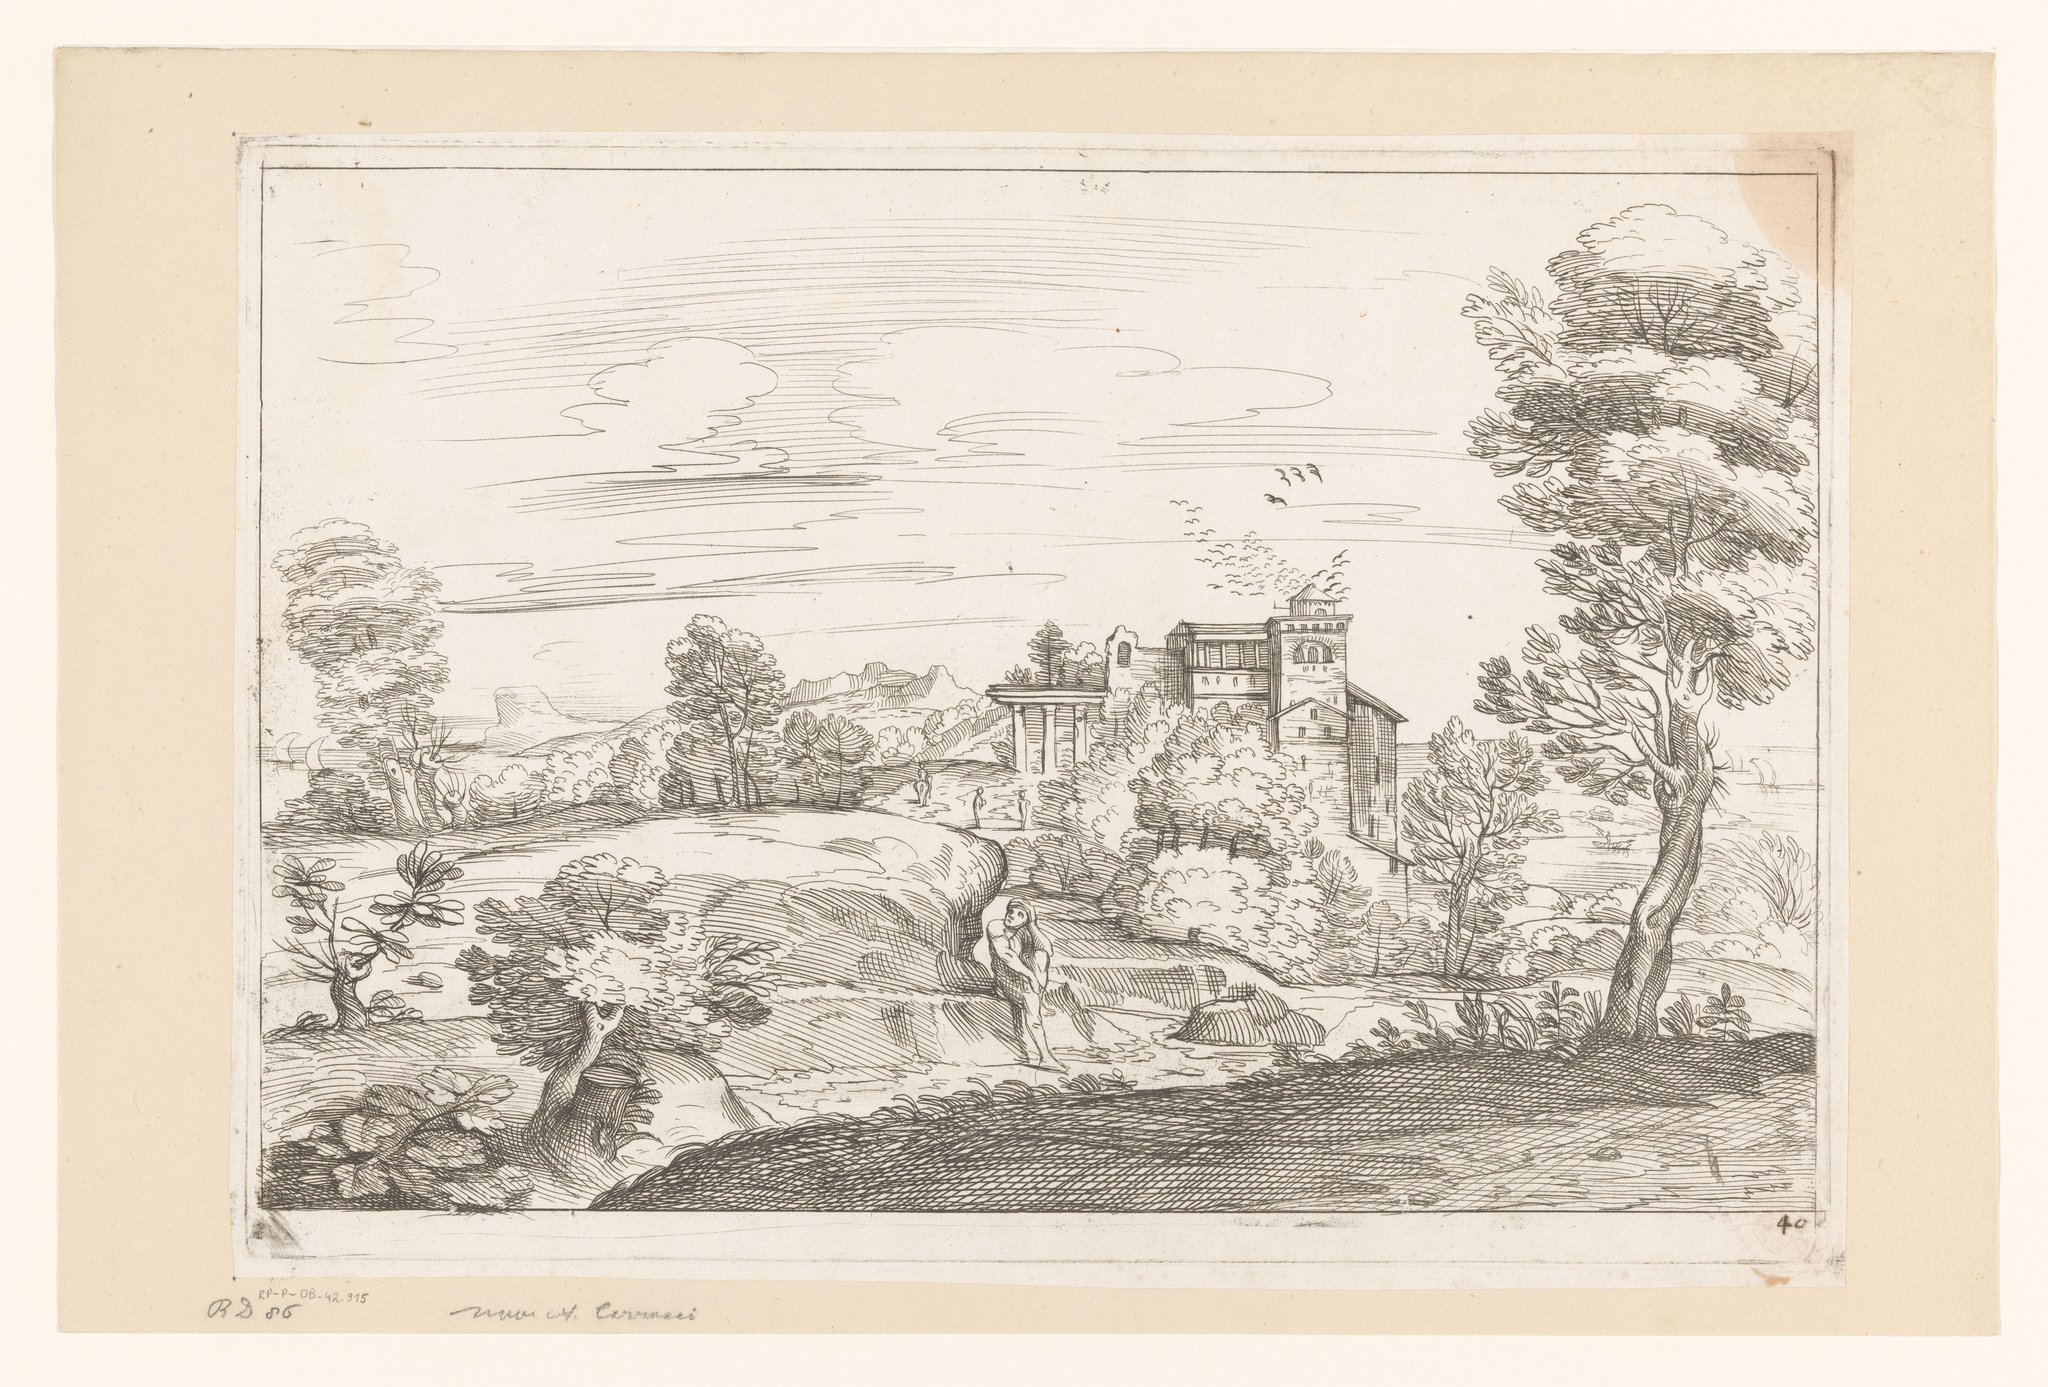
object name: print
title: Prenten naar tekeningen uit het kabinet Jabach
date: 1659-1695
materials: paper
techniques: engraving, etching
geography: france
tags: sitting figure, landscapes, rural housing, e.g. country-house, villa, cottage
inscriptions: collector's mark: Lugt 240